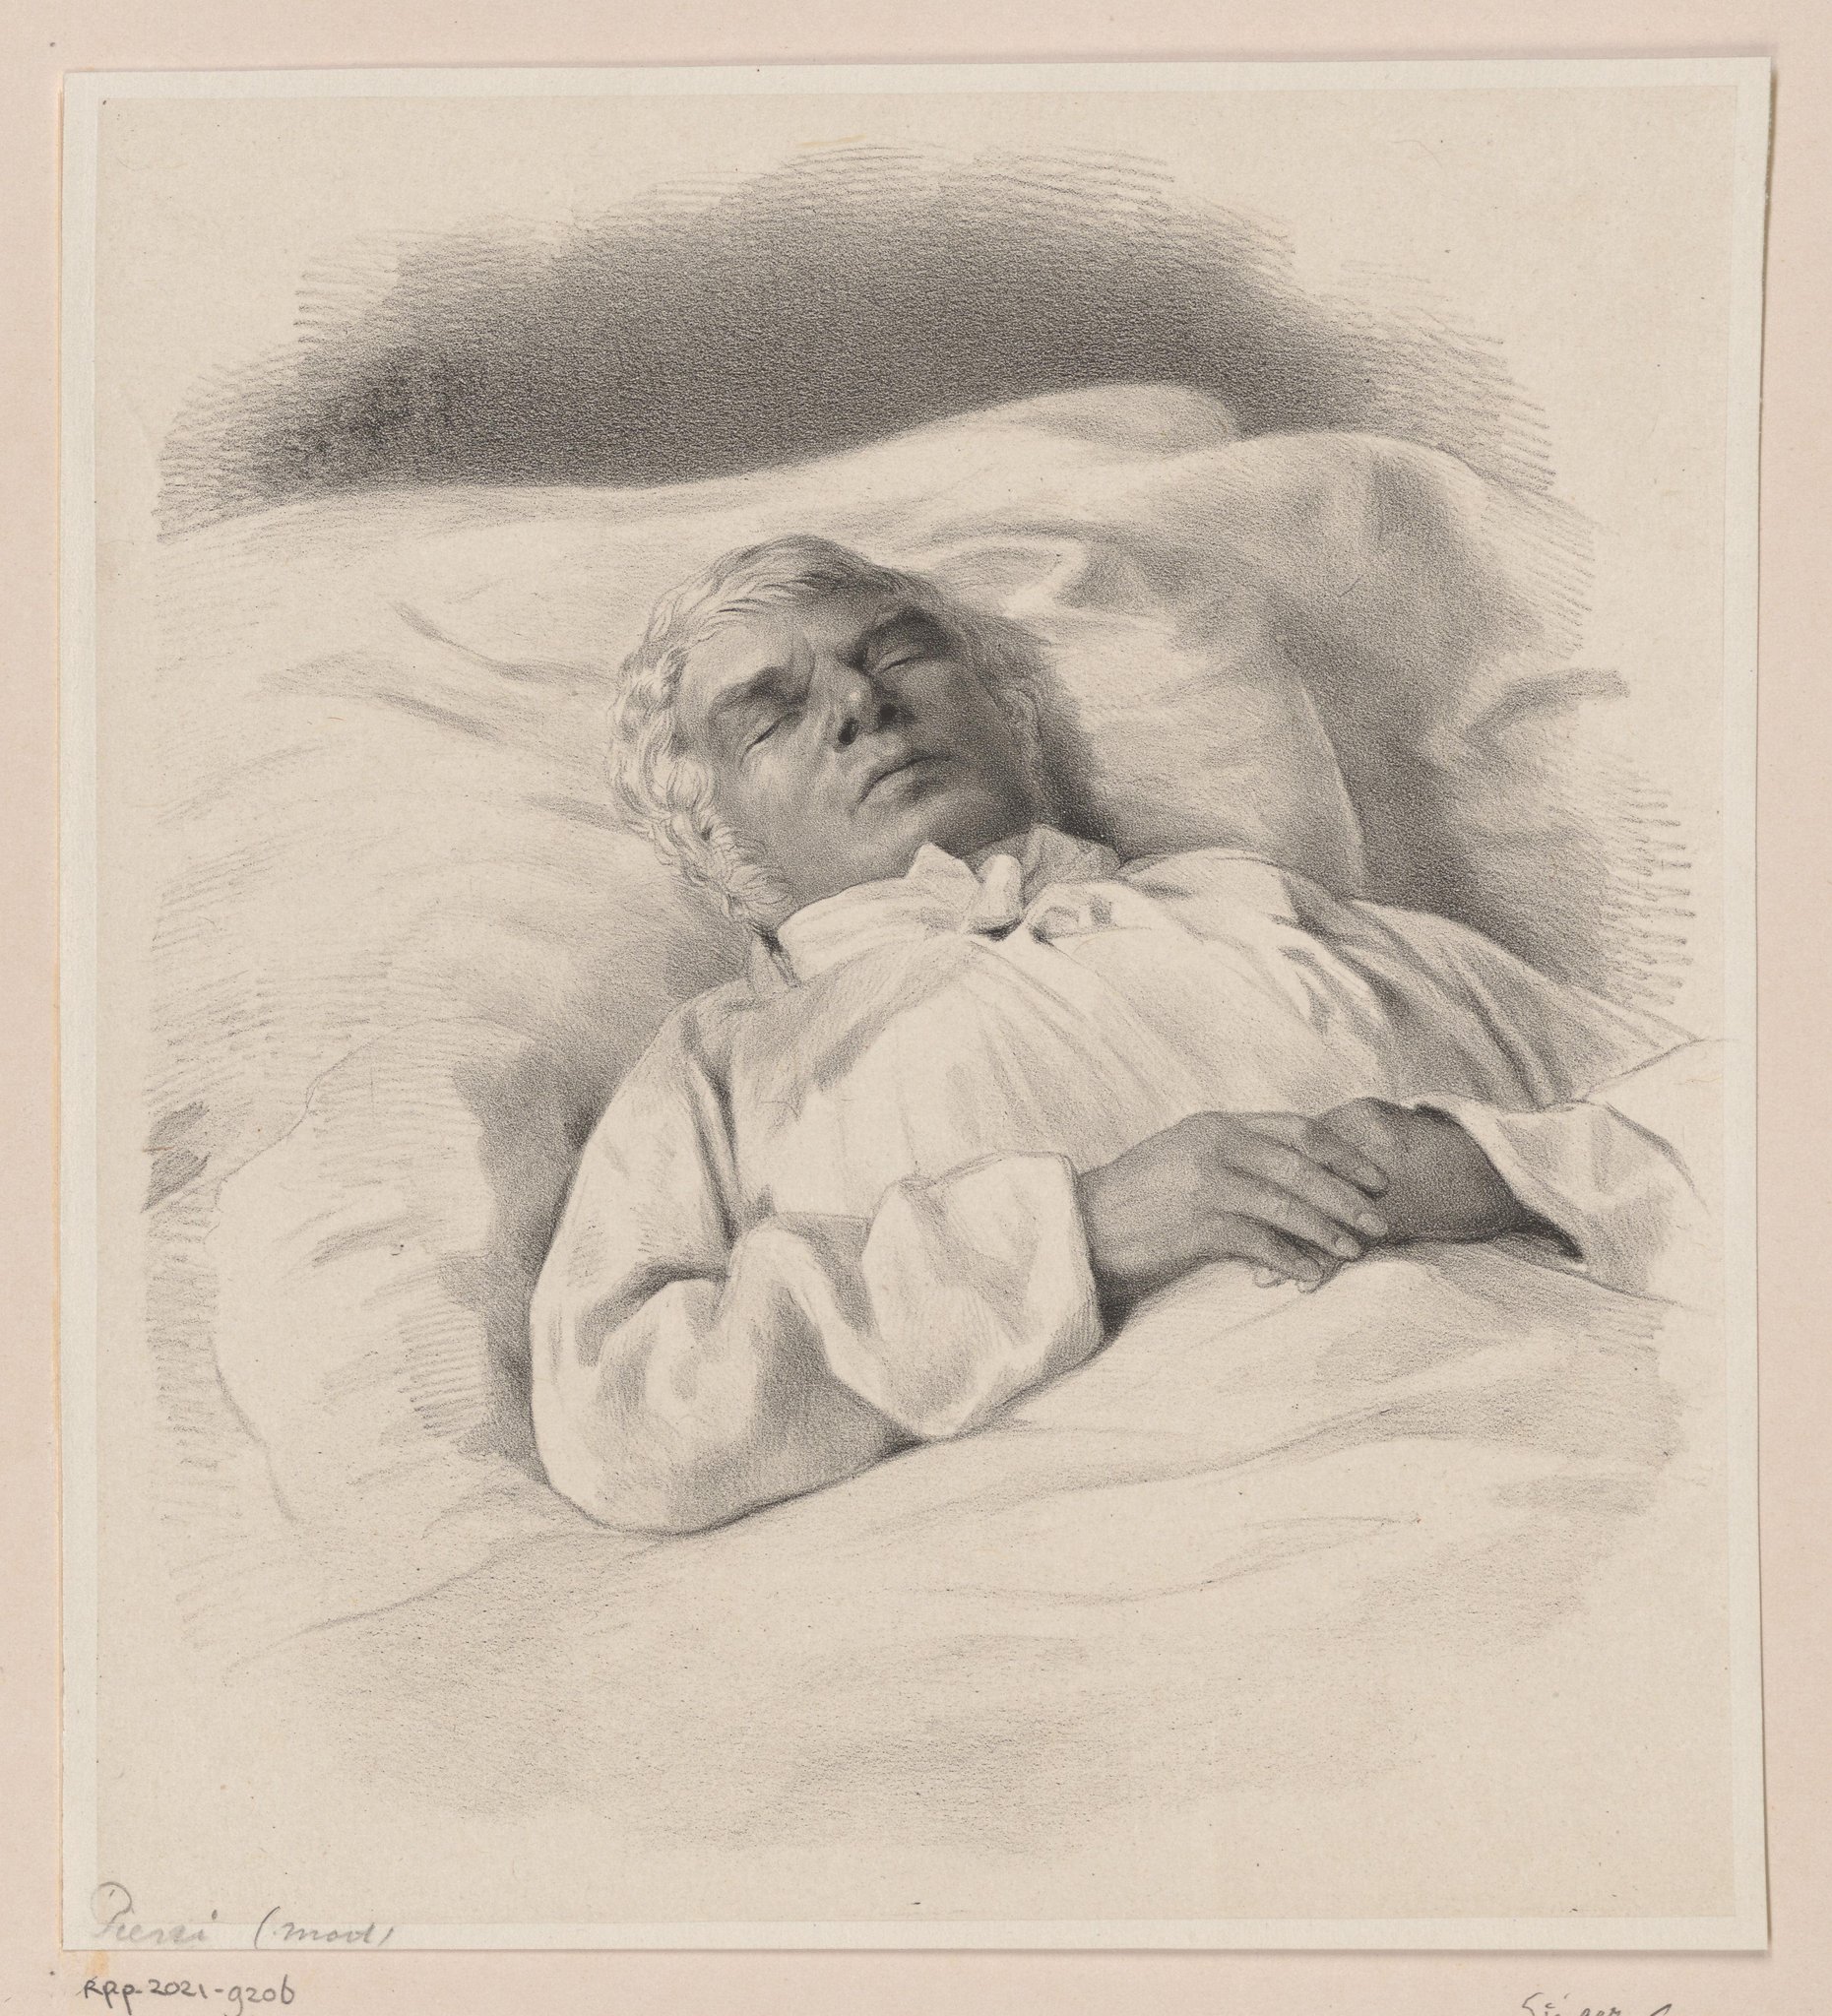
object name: print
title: Portret van een onbekende man op zijn doodsbed, mogelijk Pierri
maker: Anonymous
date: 1820-1899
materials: paper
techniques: lithograph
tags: adult man, deathbed, historical persons